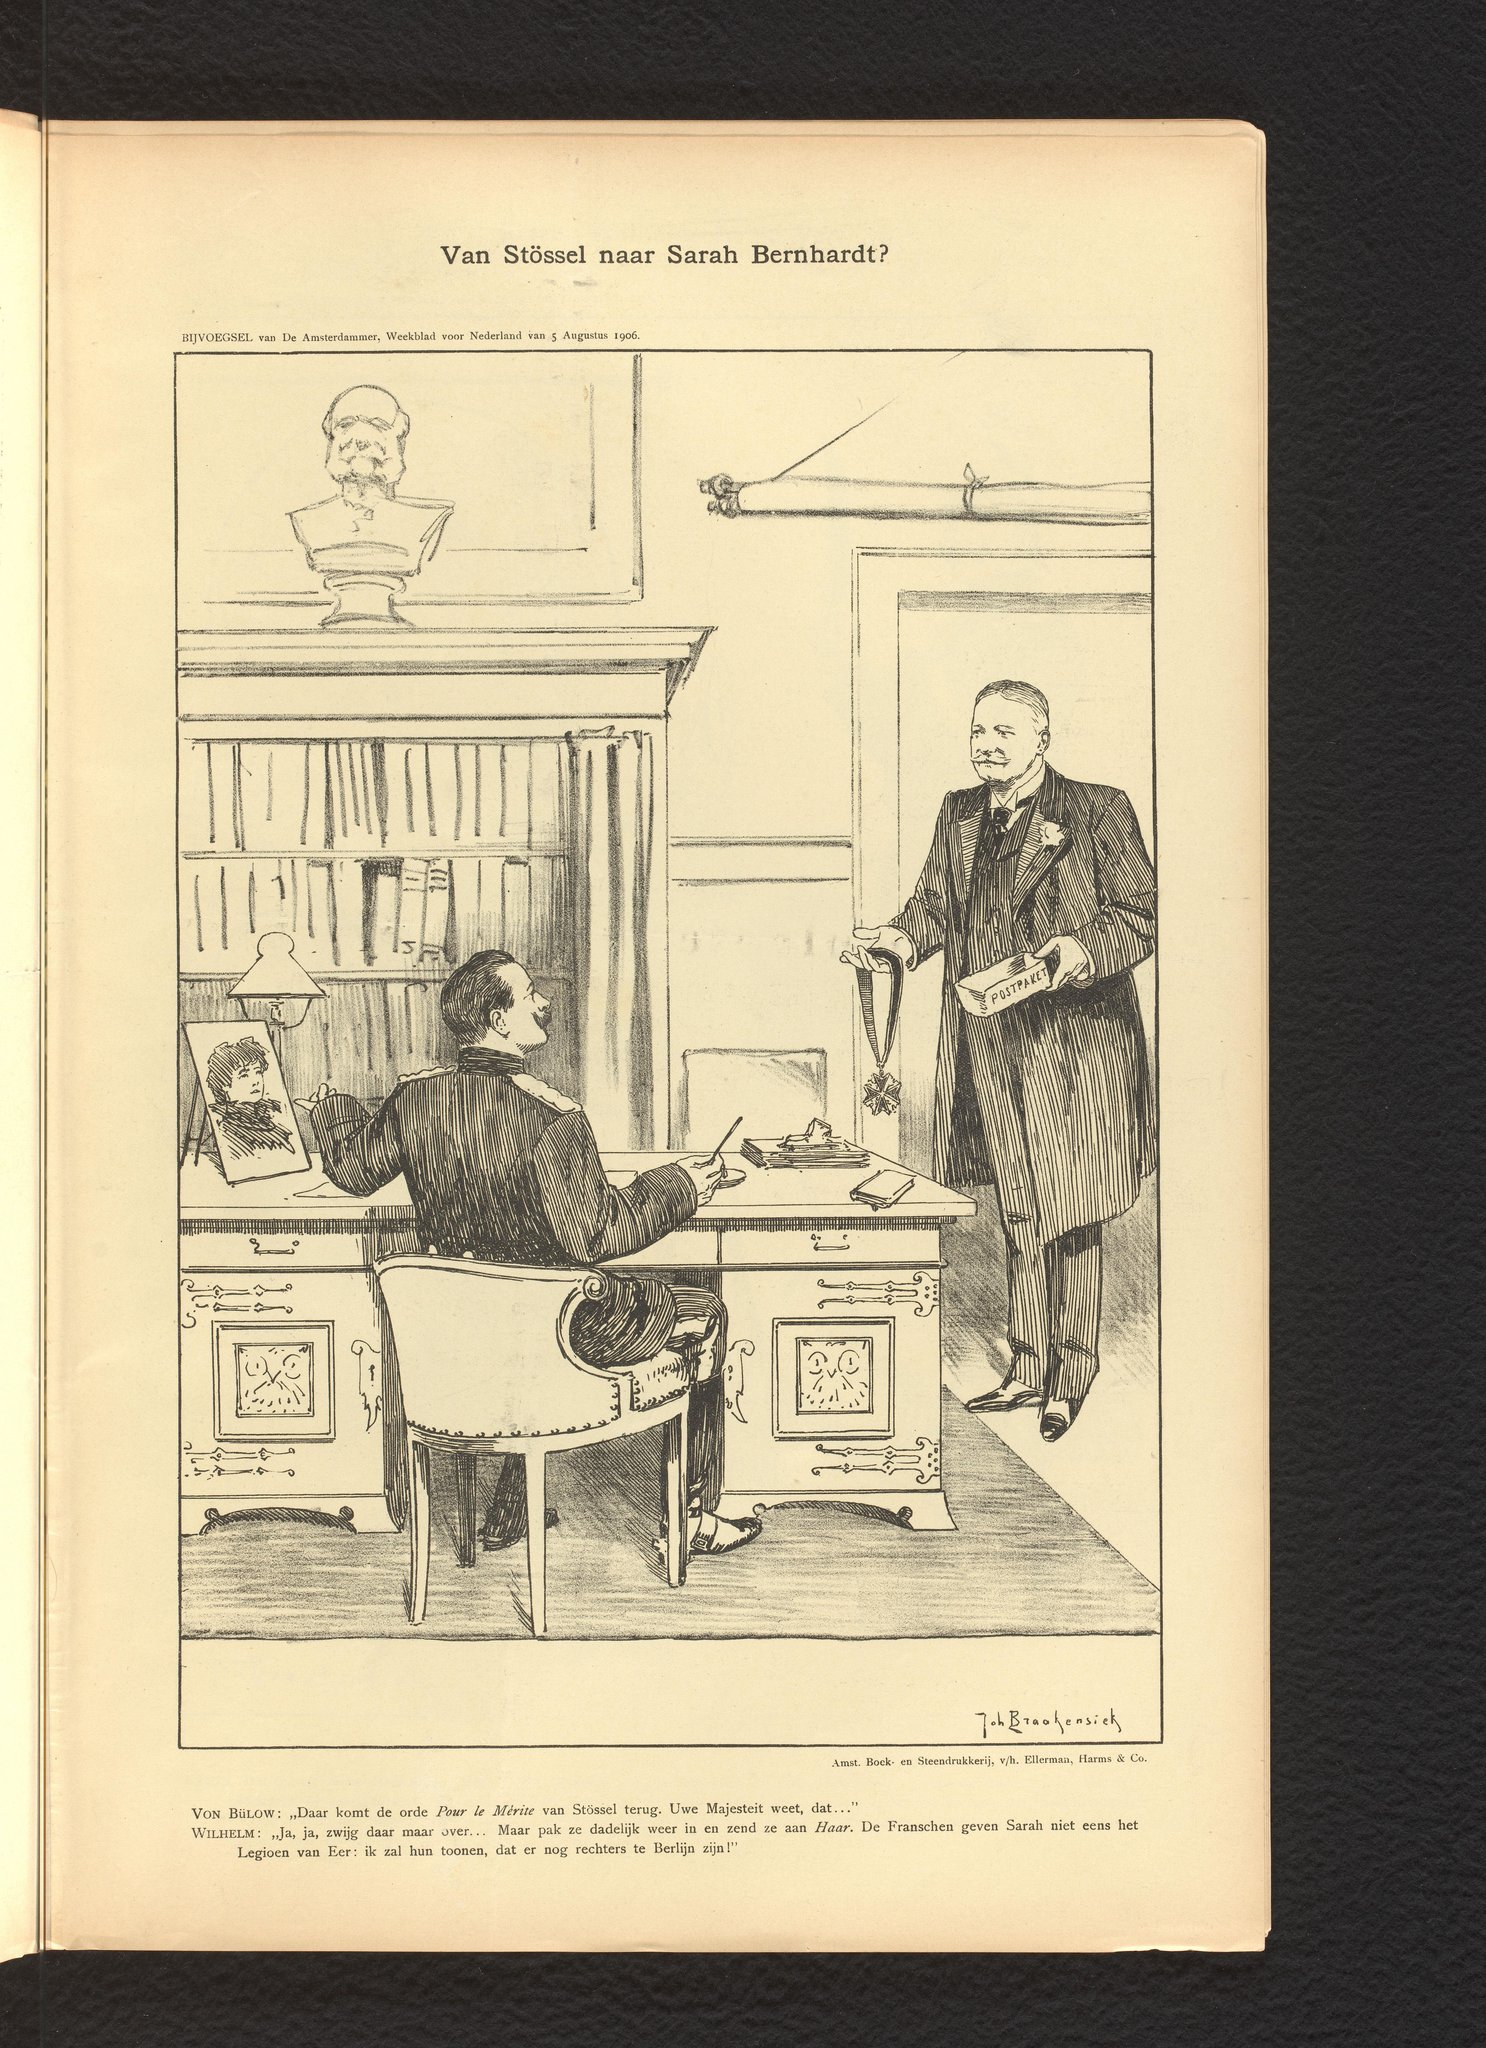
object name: cartoon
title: Van Stössel naar Sarah Bernhardt?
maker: johan braakensiek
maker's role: draughtsman, print maker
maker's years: 1858-1940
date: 1906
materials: paper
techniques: lithograph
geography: netherlands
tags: wilhelm ii (keizer van duitsland), paris, sarah bernhardt, knighthood order, political caricatures and satires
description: Kanselier Von Bülow toont de Duitse keizer Wilhelm II het ordeteken teruggestuurd door Stössel (mogelijk Anatoly Stössel). De keizer stelt voor om de onderscheiding dan maar door te sturen naar Sarah Bernhardt.